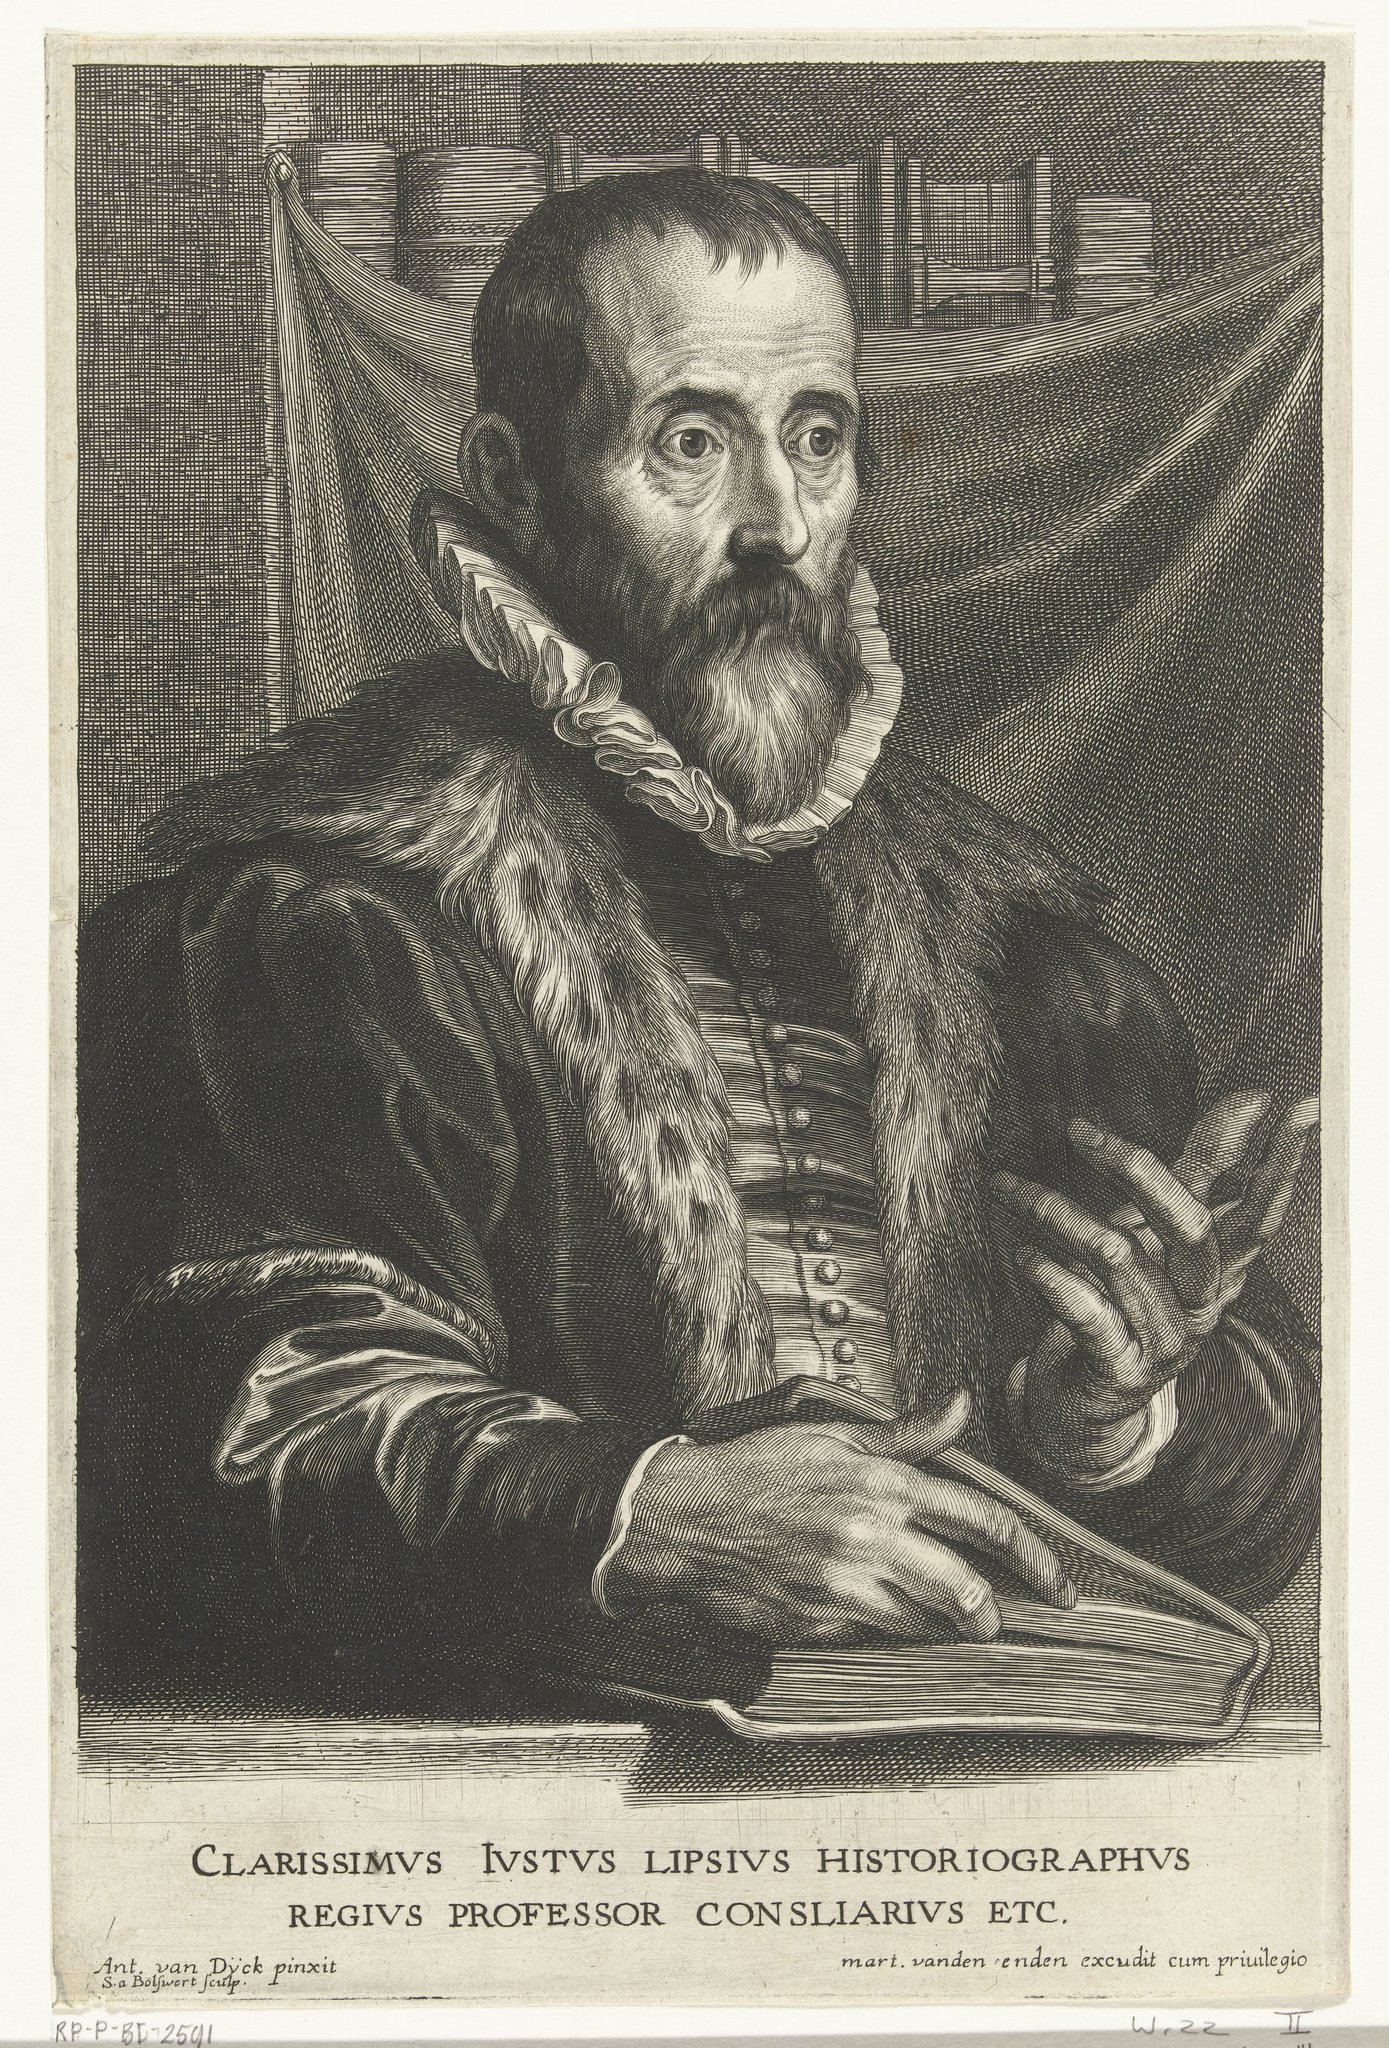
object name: print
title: Portret van historicus Justus Lipsius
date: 1596-1659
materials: paper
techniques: engraving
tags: louvain, justus lipsius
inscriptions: collector's mark: Lugt 240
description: Prent naar schilderij van Anthony van Dyck.